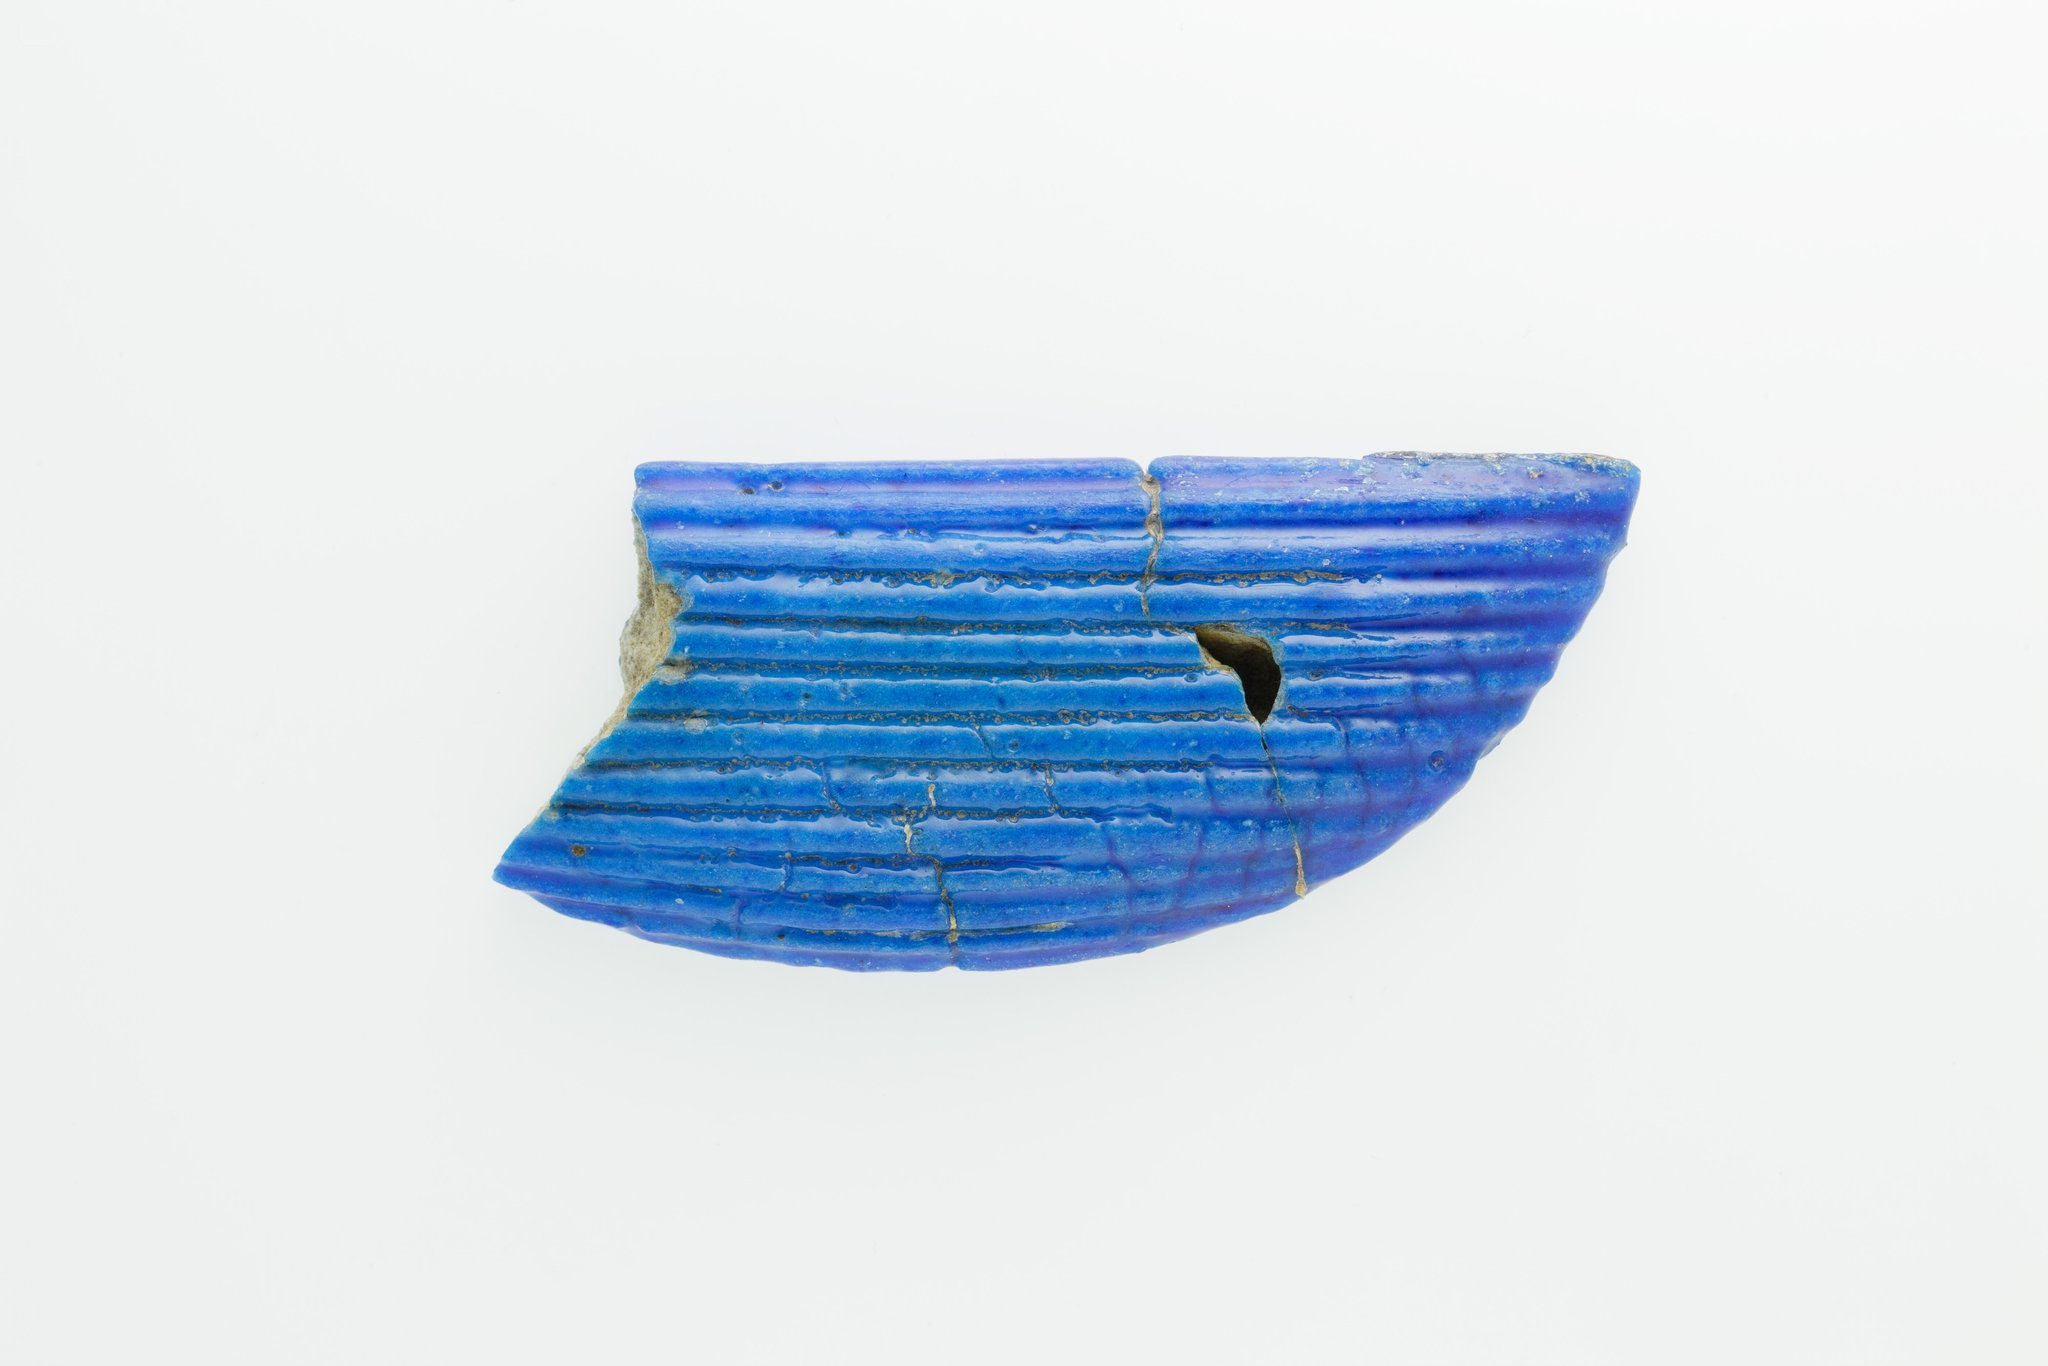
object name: inlay, hieroglyph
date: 664-610 BCE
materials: faience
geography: egypt